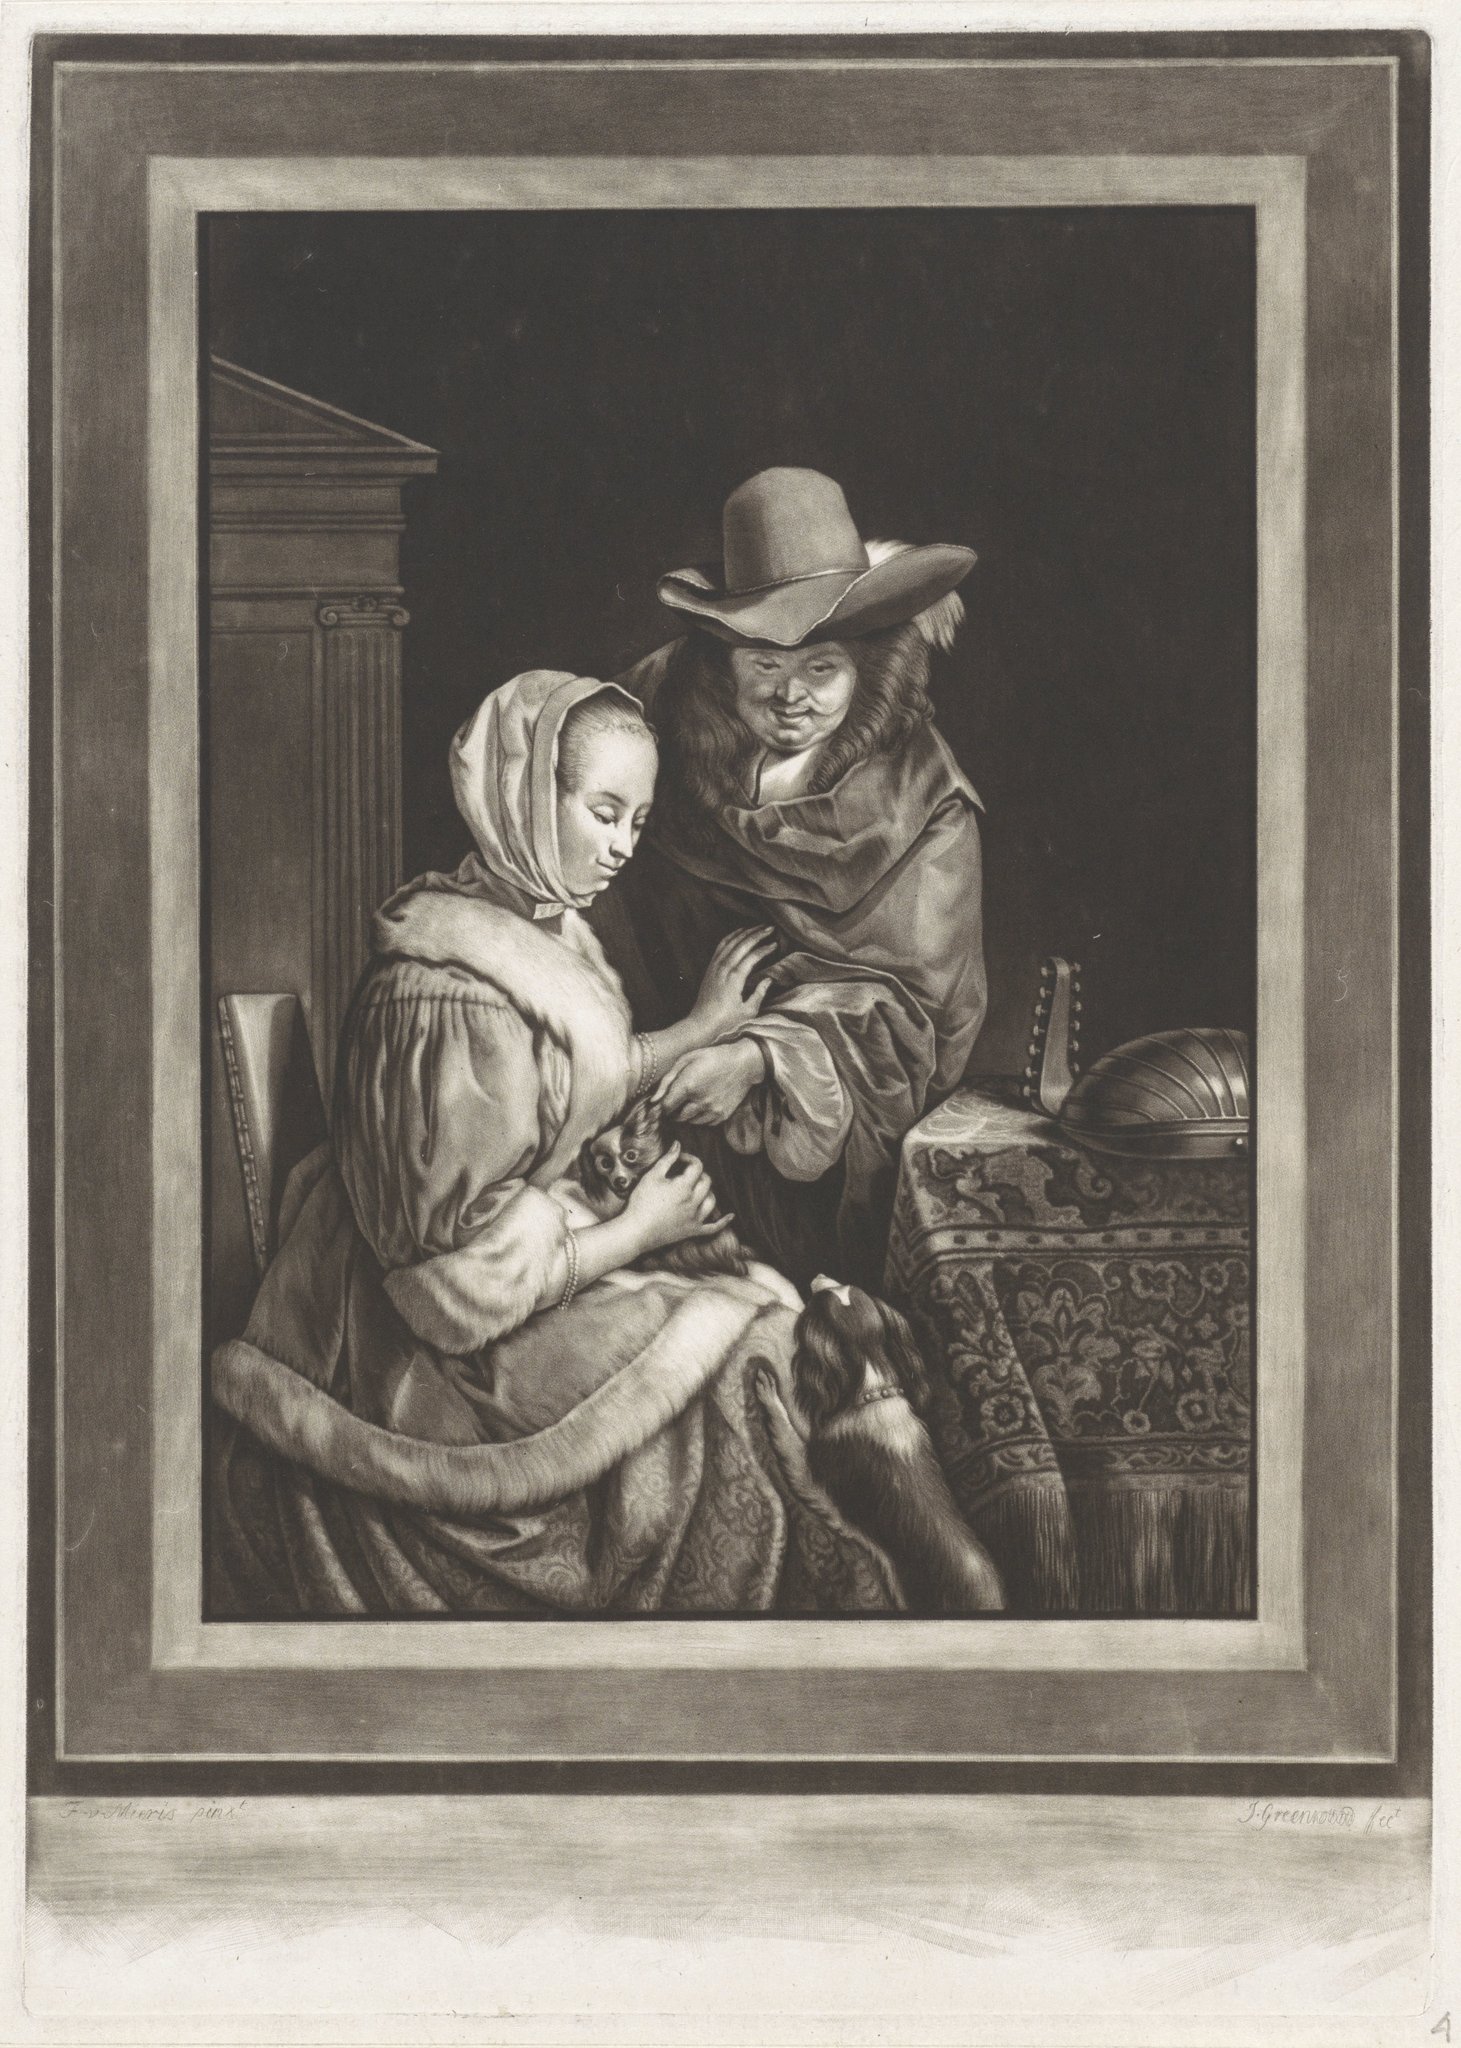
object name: print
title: Een man en een vrouw met twee honden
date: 1739-1792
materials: paper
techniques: mezzotint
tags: lute, and special forms of lute, e.g.: theorbo, dog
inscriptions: collector's mark: Lugt 240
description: Interieur met een man die een hondje aait dat op de schoot van een elegant geklede vrouw zit. Een tweede hondje staat tegen de rokken van de vrouw. Op de tafel ligt een luit.